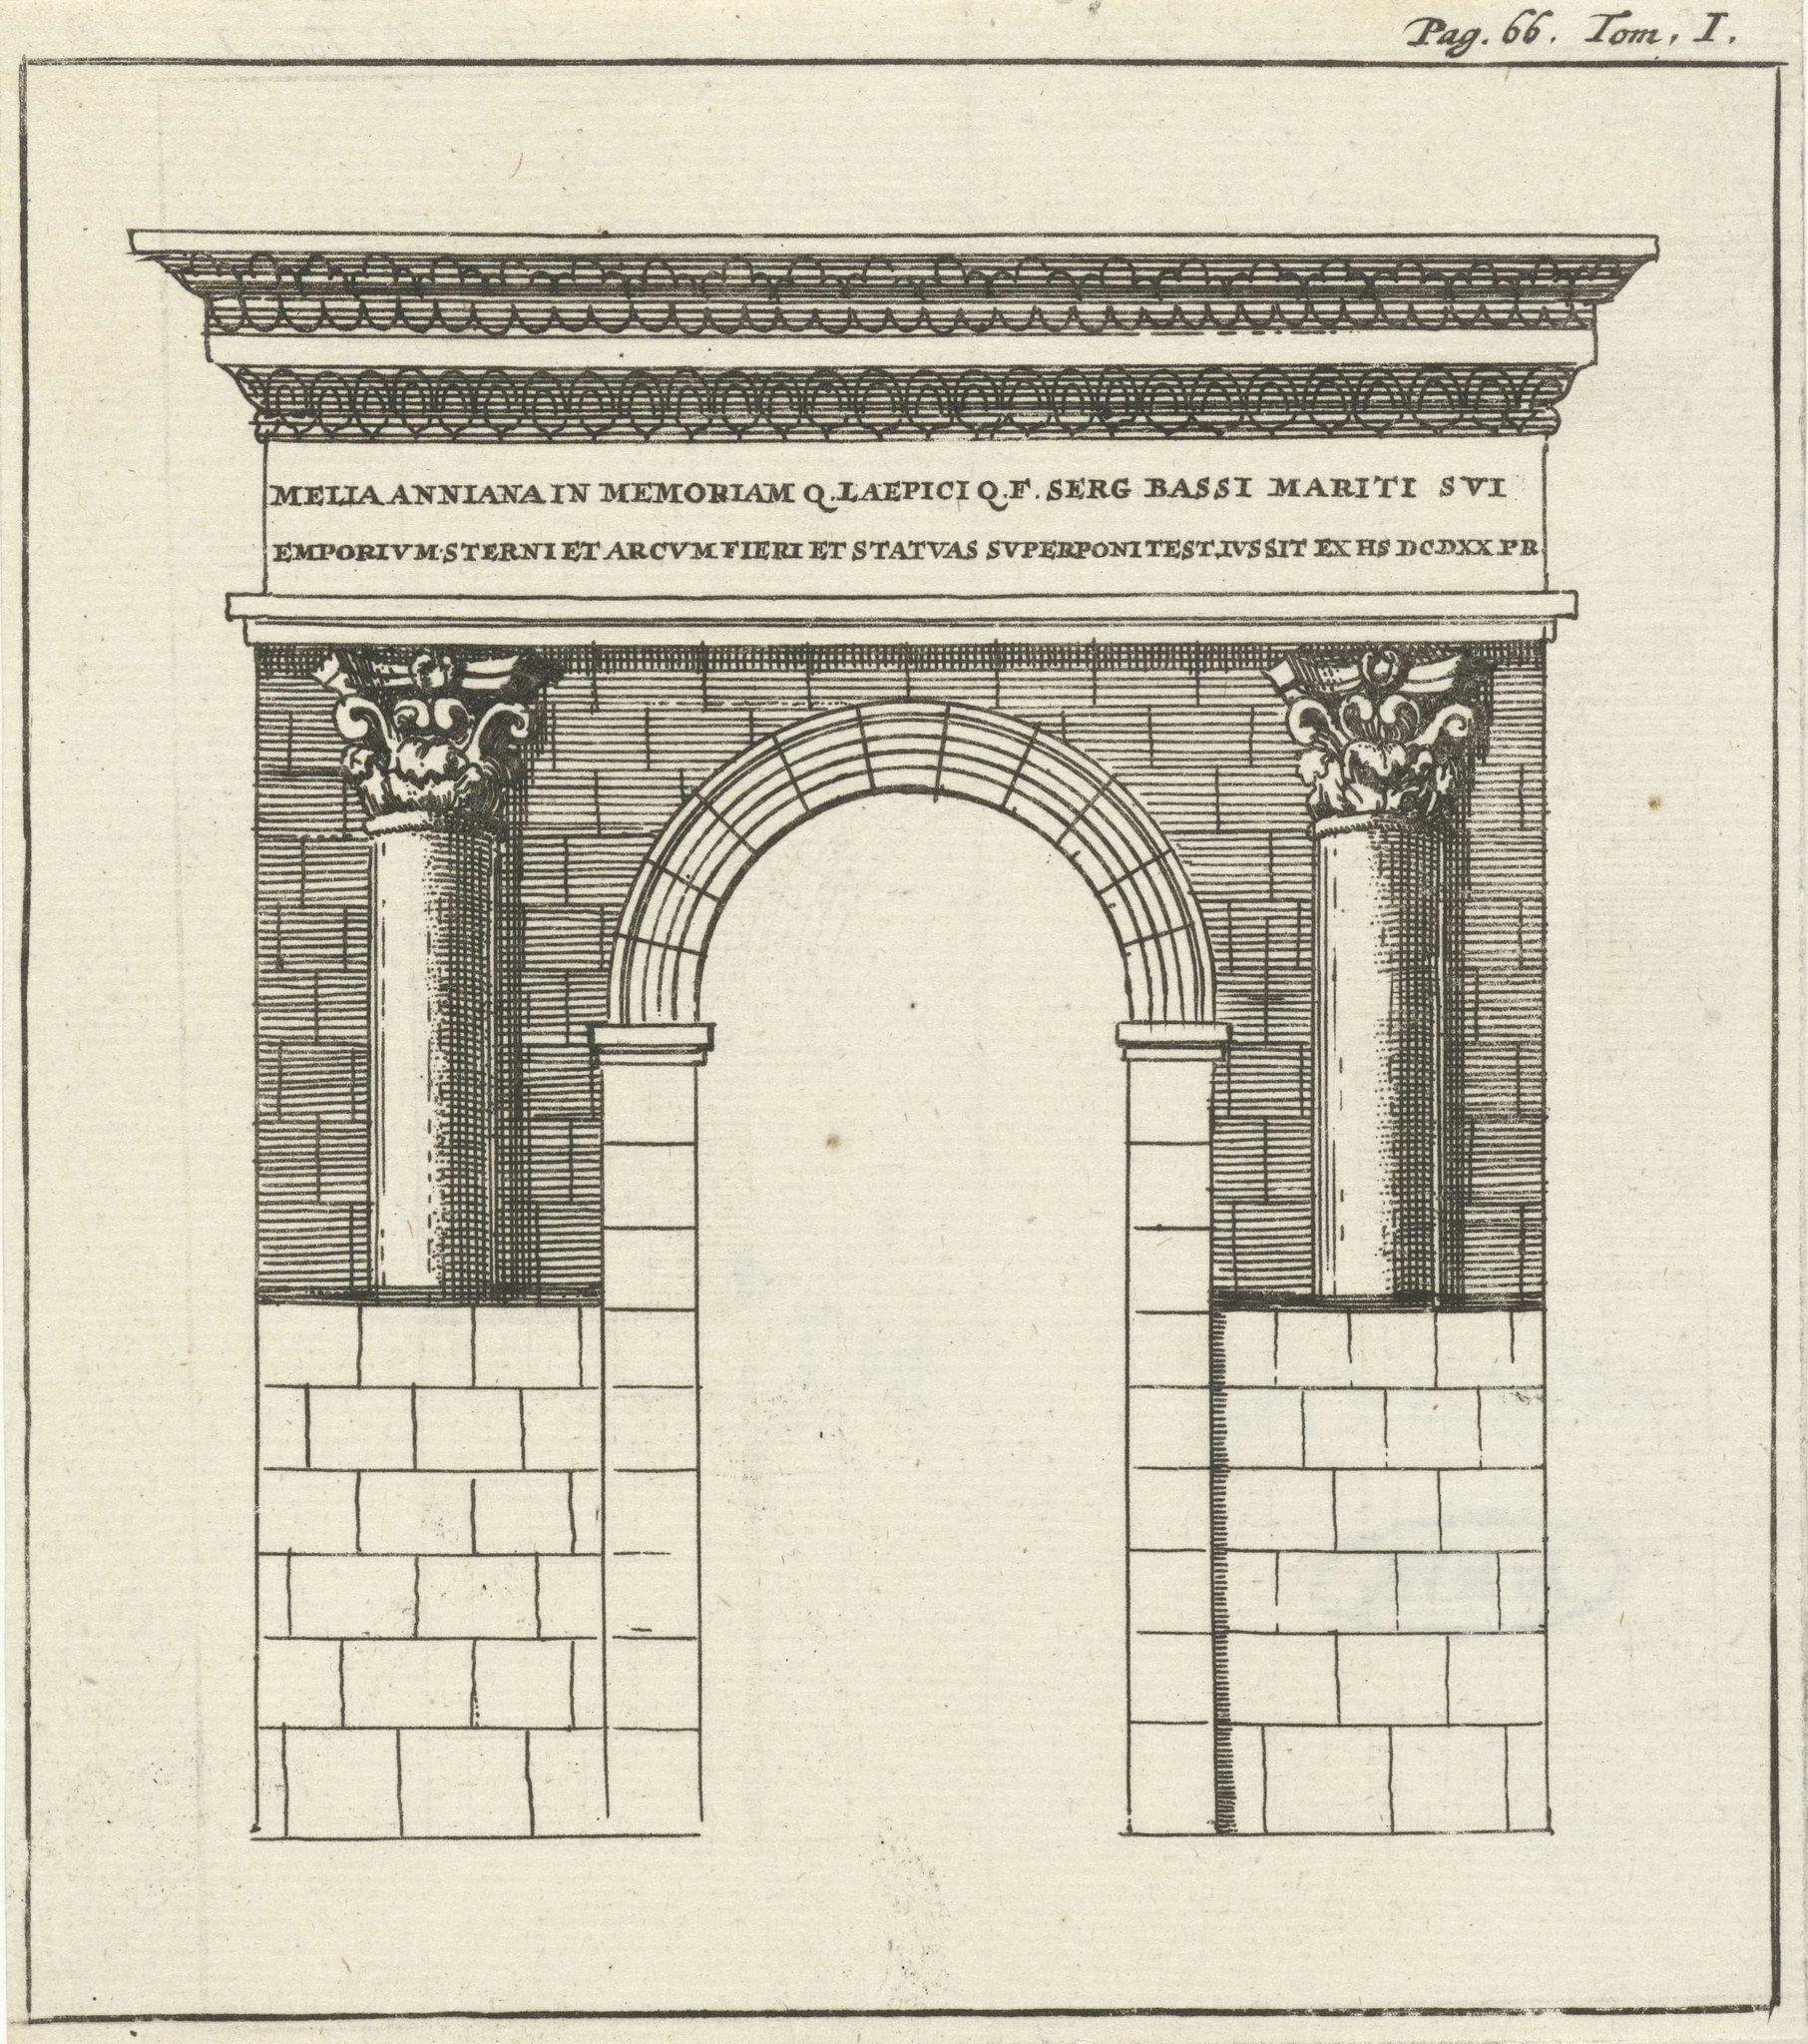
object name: book illustration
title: Romeinse poort bij Zara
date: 1679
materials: paper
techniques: etching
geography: amsterdam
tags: triumphal arch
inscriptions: collector's mark: Lugt 2228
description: Illustratie opgenomen in: Spon, Jacob. Voyage d'Italie, de Dalmatie, de Grece, et du Levant, 2 delen. Amsterdam: Hendrick en Dirk Boom, 1679, dl. I, p. 66.